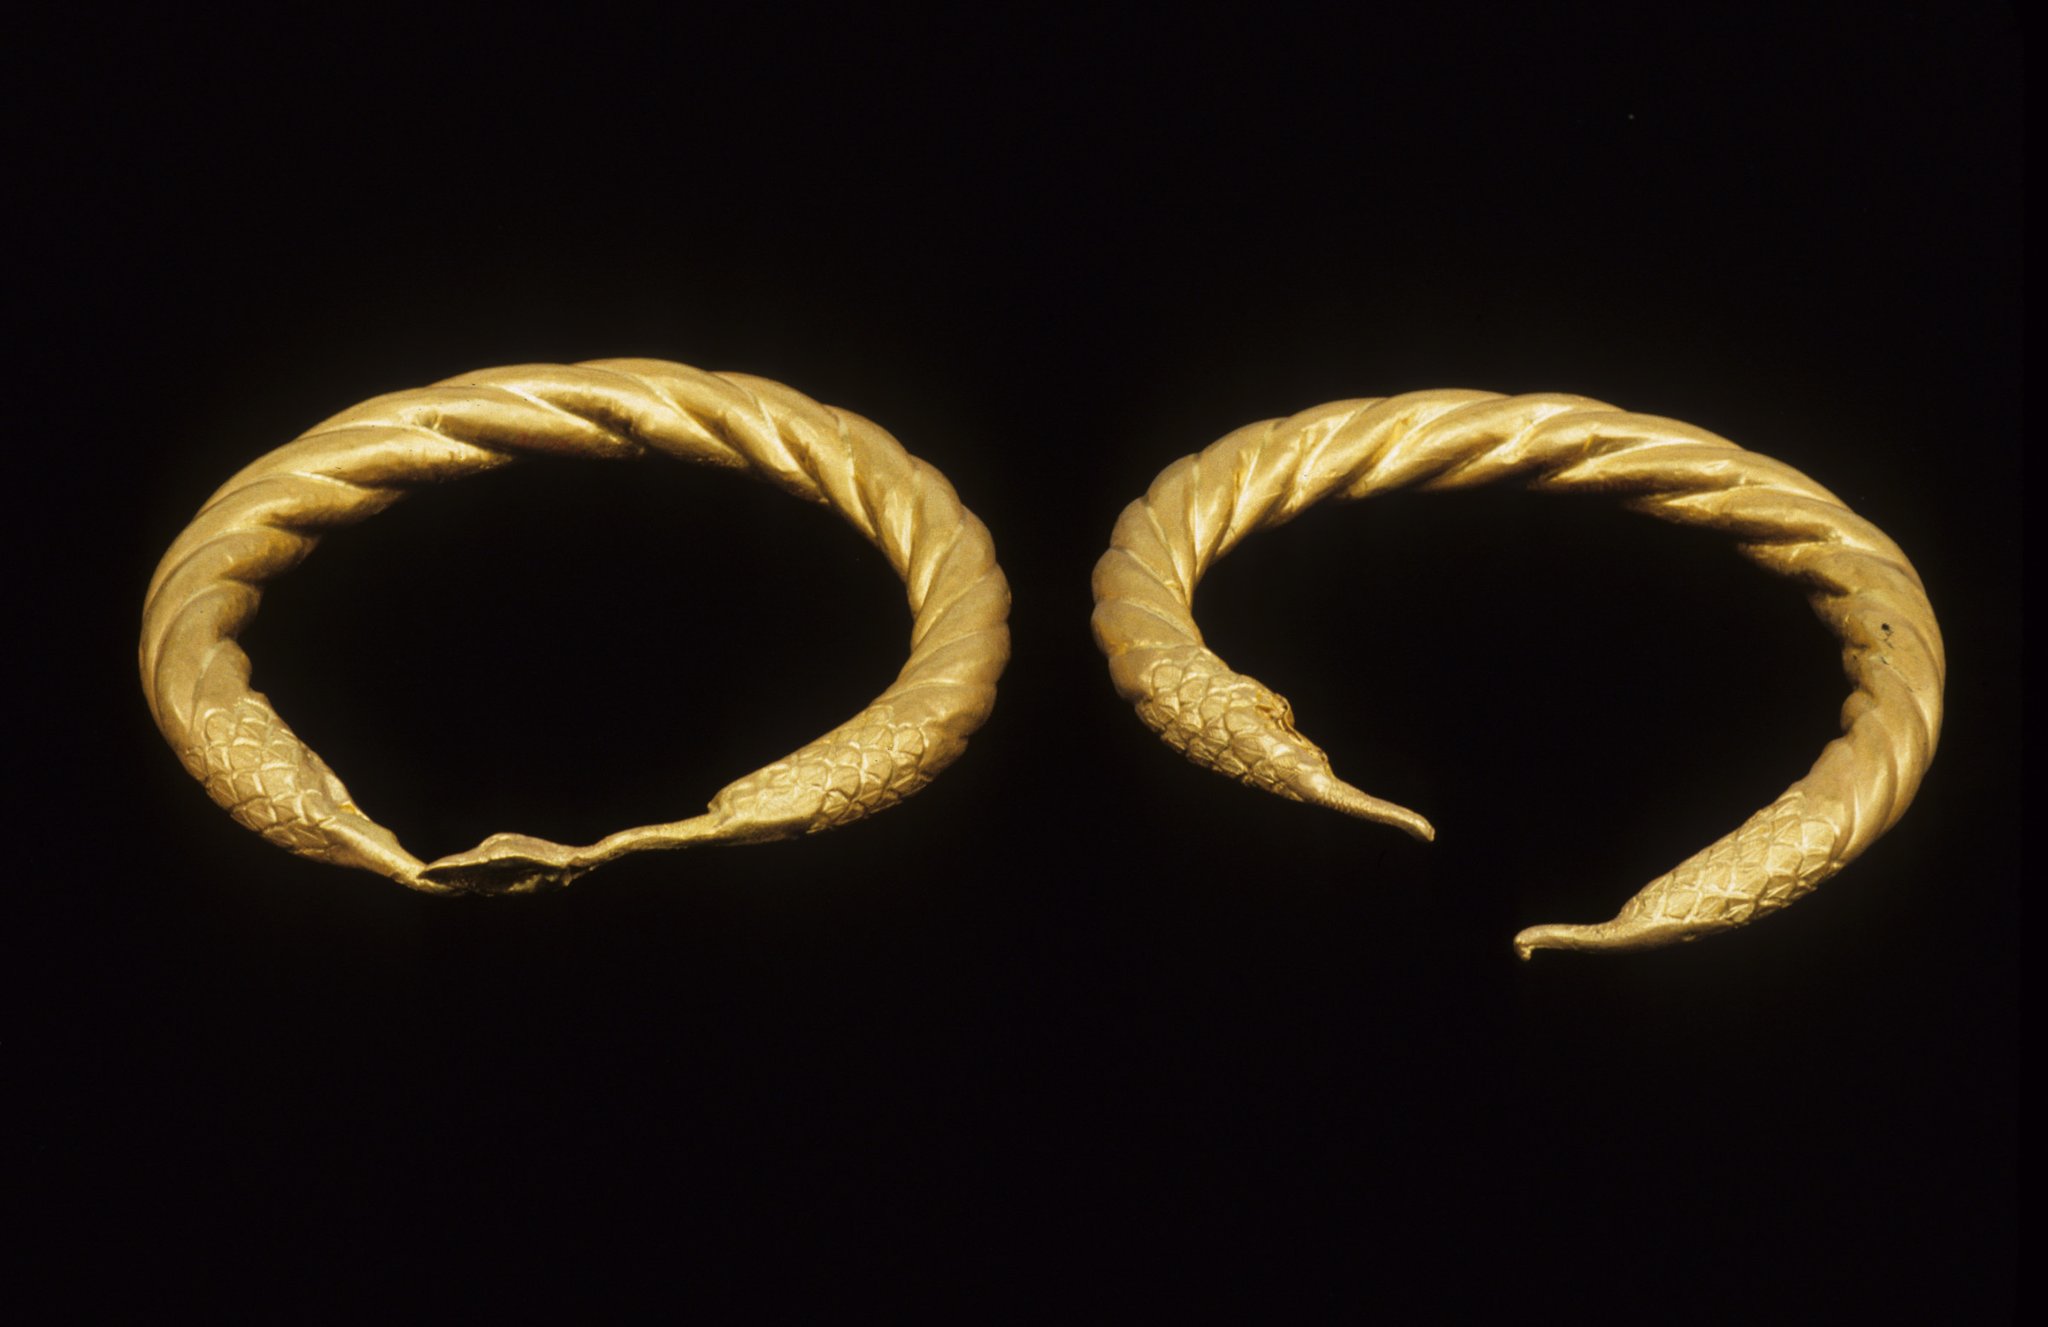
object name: armlet, goose head terminal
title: Spirally twisted tubular armlet with one goose-head terminal preserved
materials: gold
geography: memphite region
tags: birds